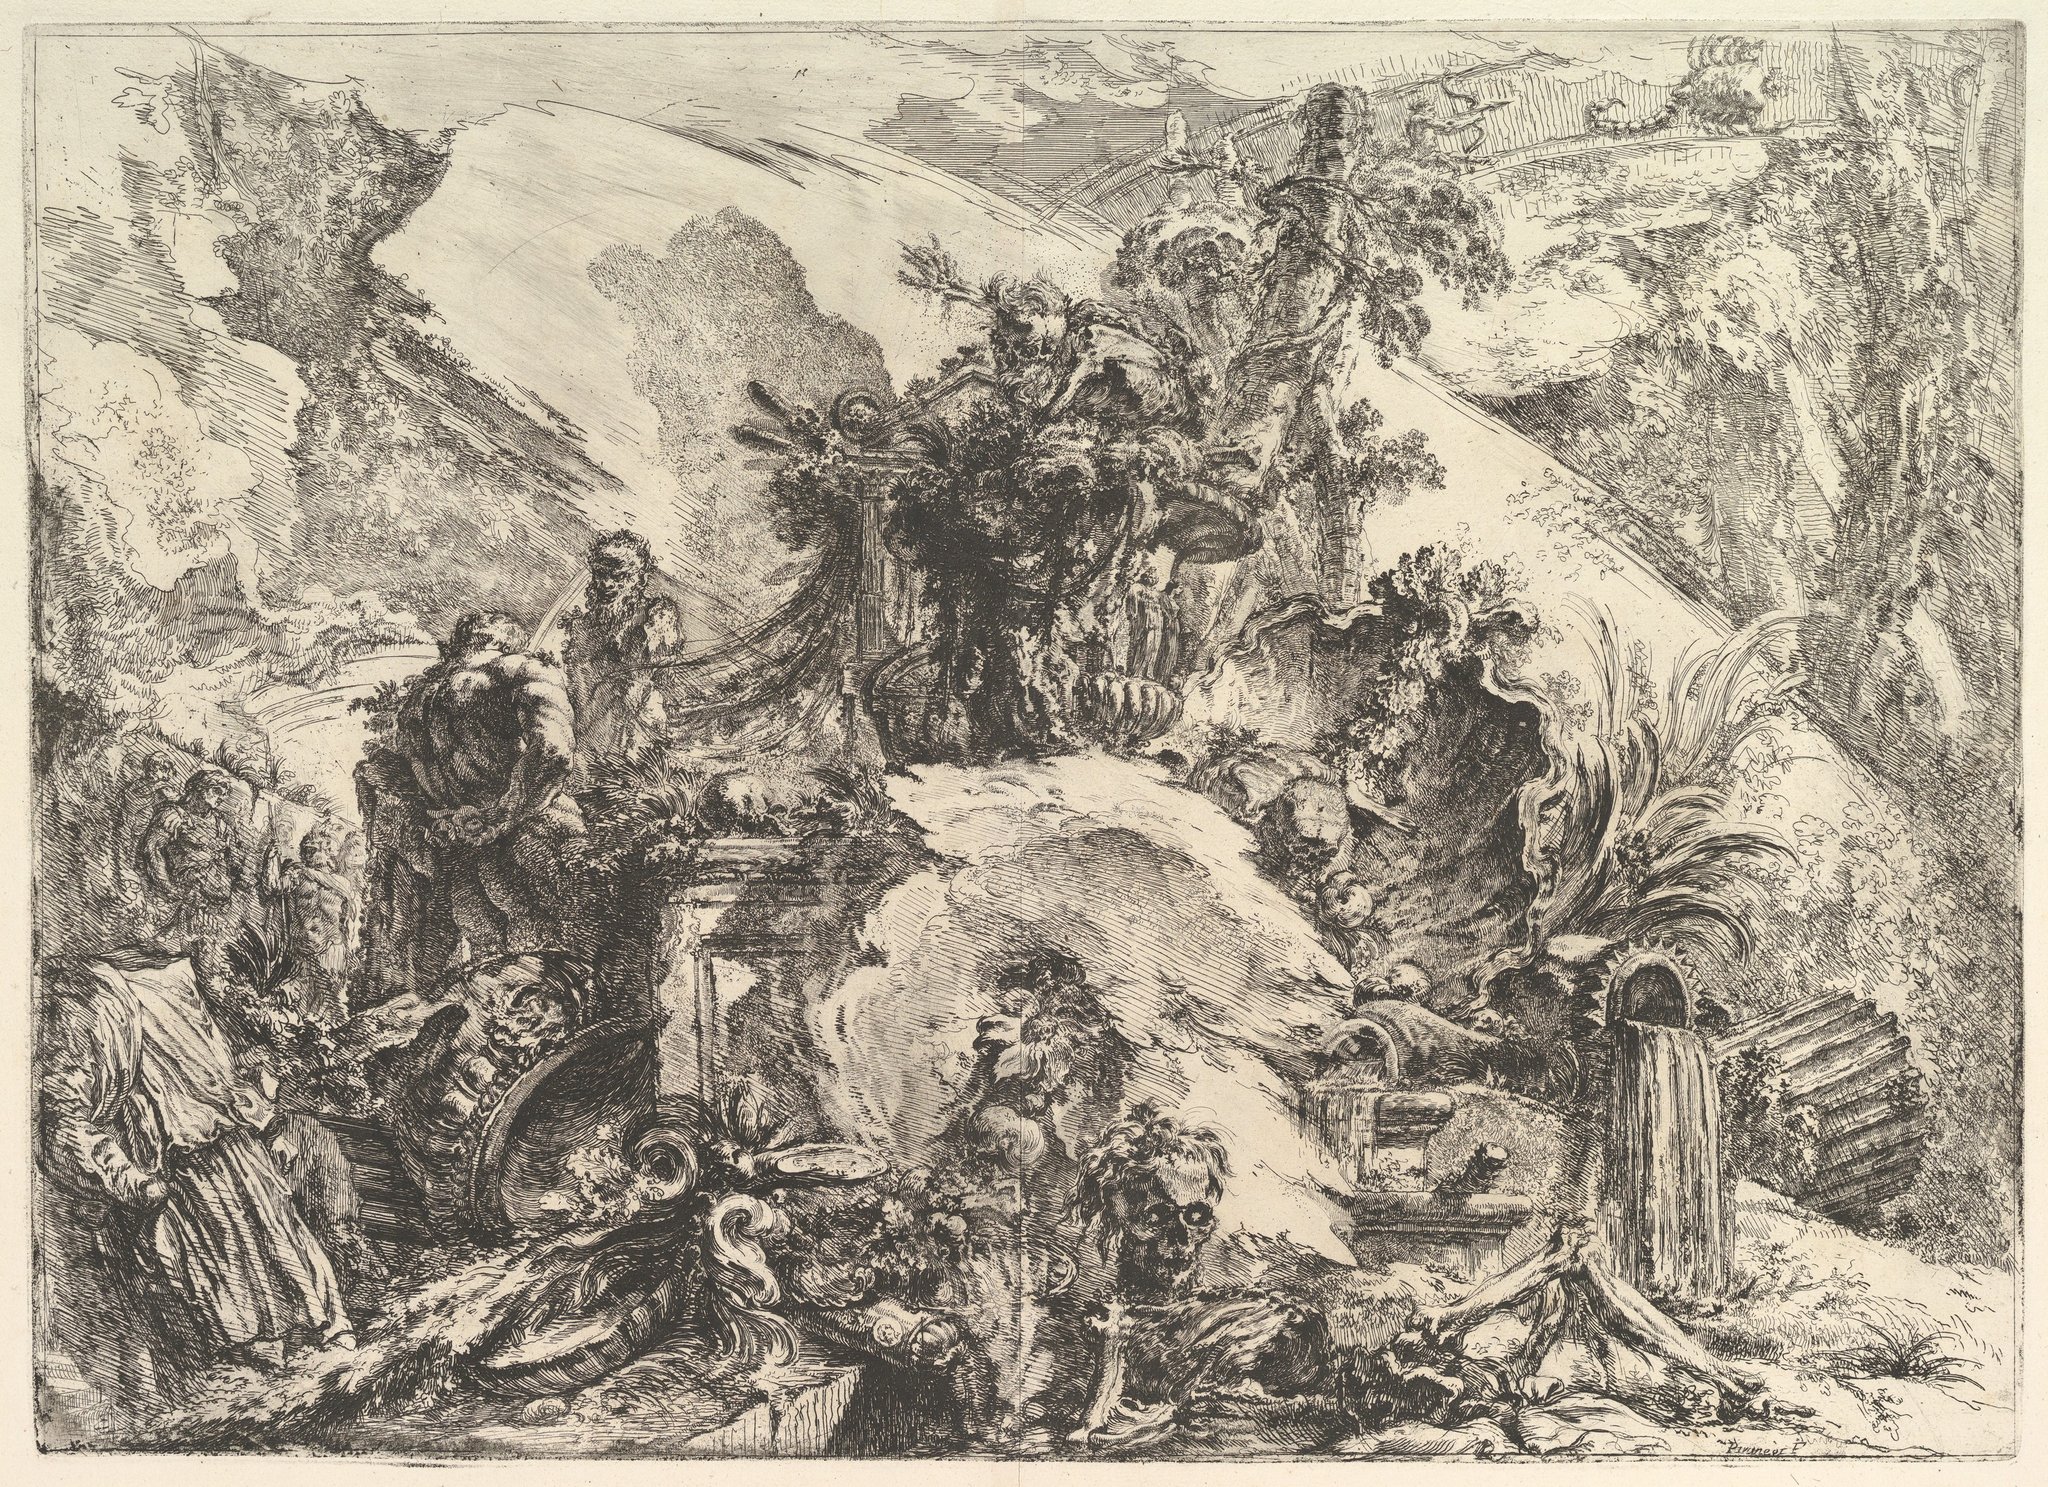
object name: print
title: The Skeletons, from "Grotteschi" (Grotesques)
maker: giovanni battista piranesi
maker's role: artist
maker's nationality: italian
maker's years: 1720-1778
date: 1748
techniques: burnishing, drypoint, engraving, etching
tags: skeletons